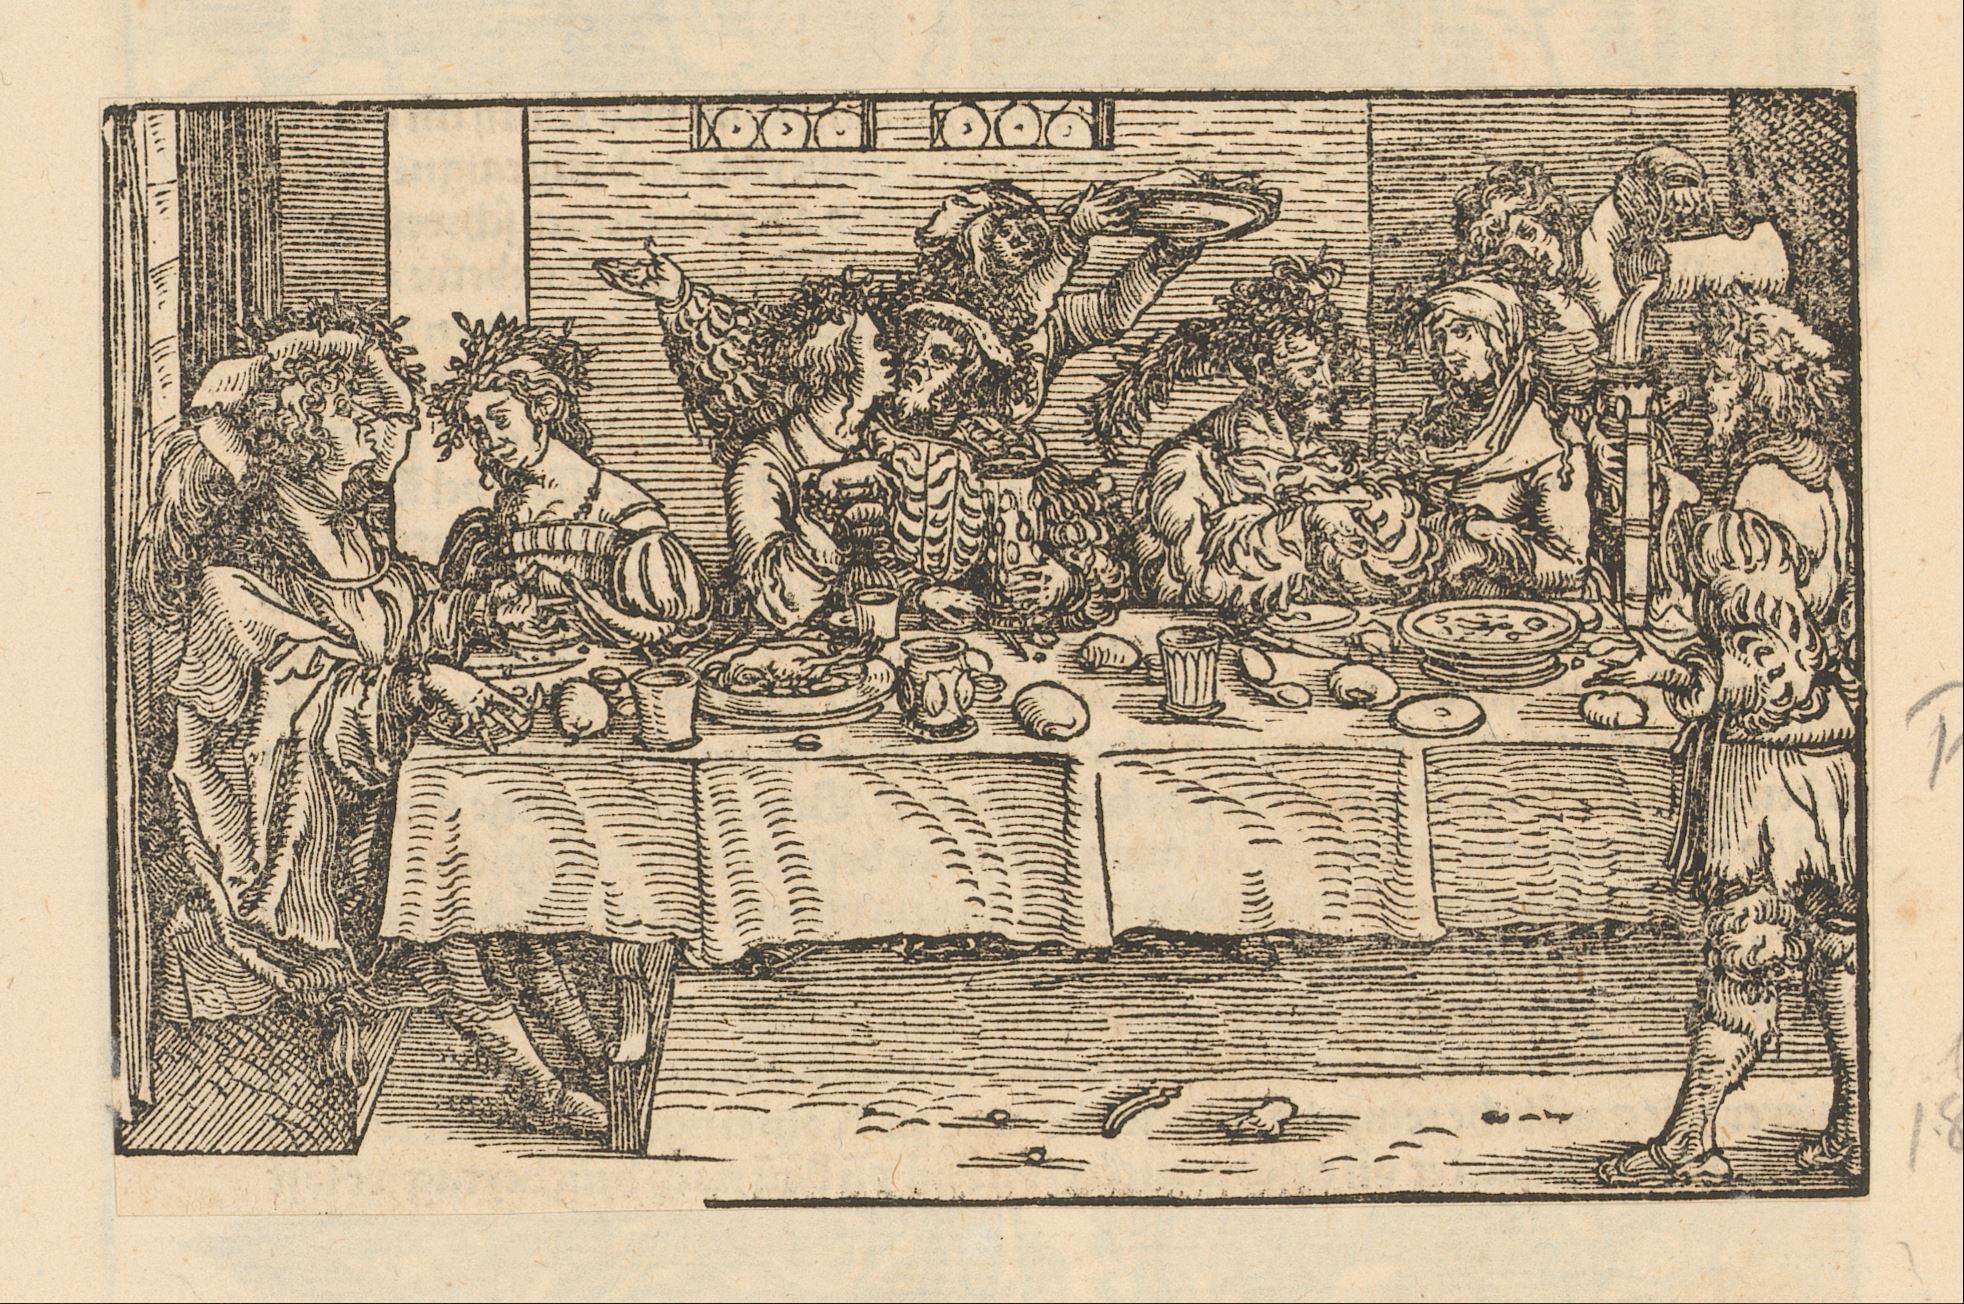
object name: album leaf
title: Drie stellen aan een overdadig diner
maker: Anonymous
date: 1514-1532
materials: paper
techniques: letterpress printing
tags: celebration meal, feast, banquet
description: Deze prent is gebruikt in: Petrarca, Francesco. Von der Artzney bayder Glück, des guten und widerwertigen: unnd weß sich ain yeder inn Gelück und Unglück halten sol (...). Augsburg: Heinrich Steiner, 1532. Deze uitgave is ook bekend onder de titel 'Trostspiegel in Glück und Unglück'.